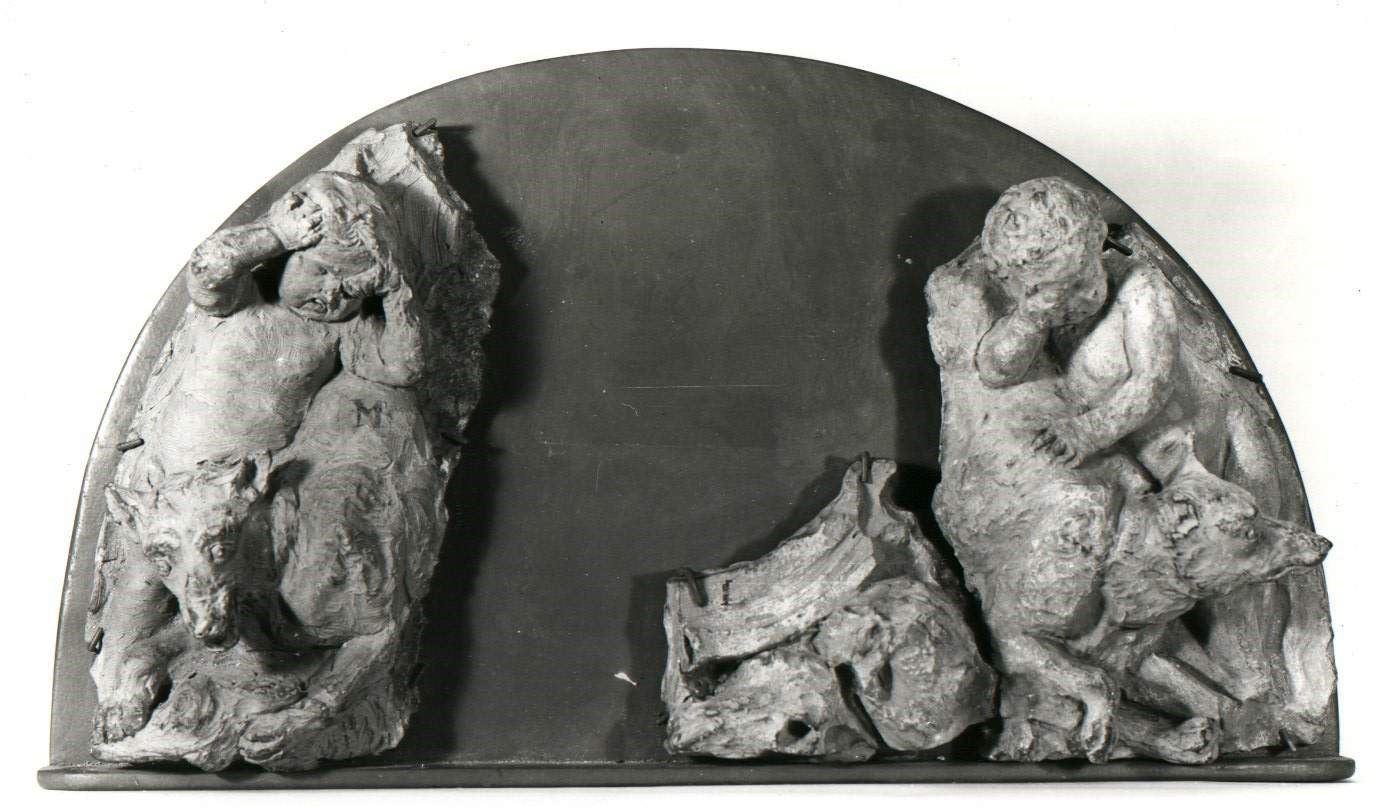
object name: sculpture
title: Model for an Overdoor Lunette with Putti and Wolves for the Amsterdam Town Hall (now Royal Palace) at Dam Square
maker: artus quellinus (i)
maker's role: draughtsman, print maker, sculptor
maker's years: 1609-1668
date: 1652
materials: terracotta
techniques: modeling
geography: amsterdam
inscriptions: inscription, on the right fragment, in black ink: ‘M’